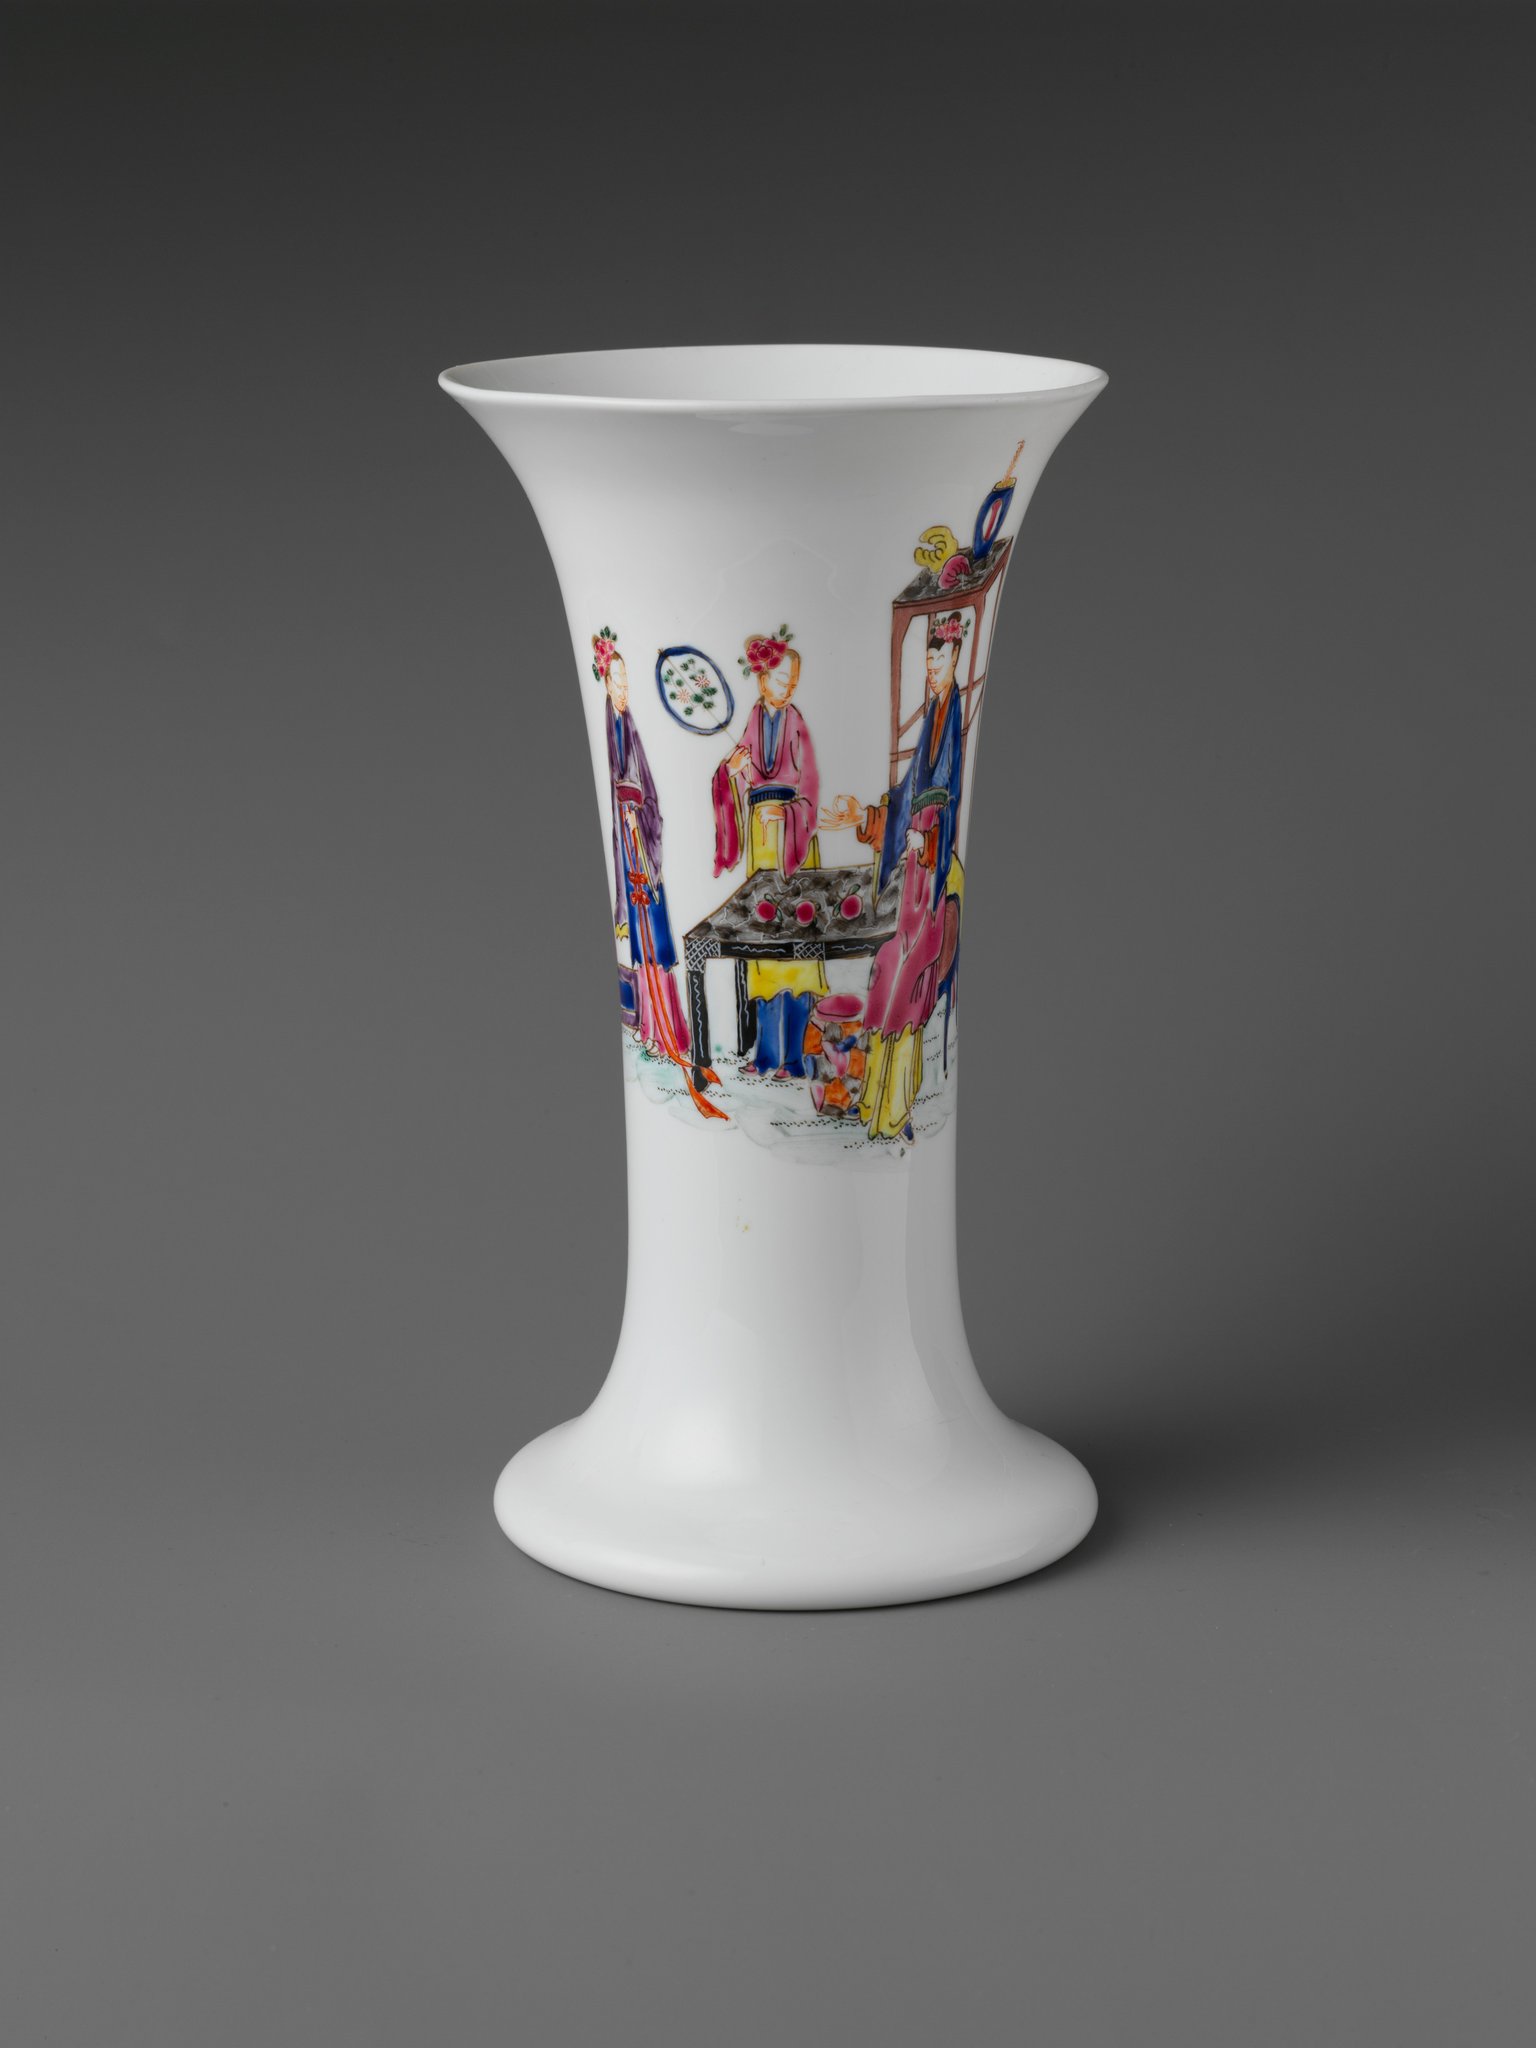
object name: beaker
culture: british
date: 1760-1765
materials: enamel, glass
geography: england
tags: human figures